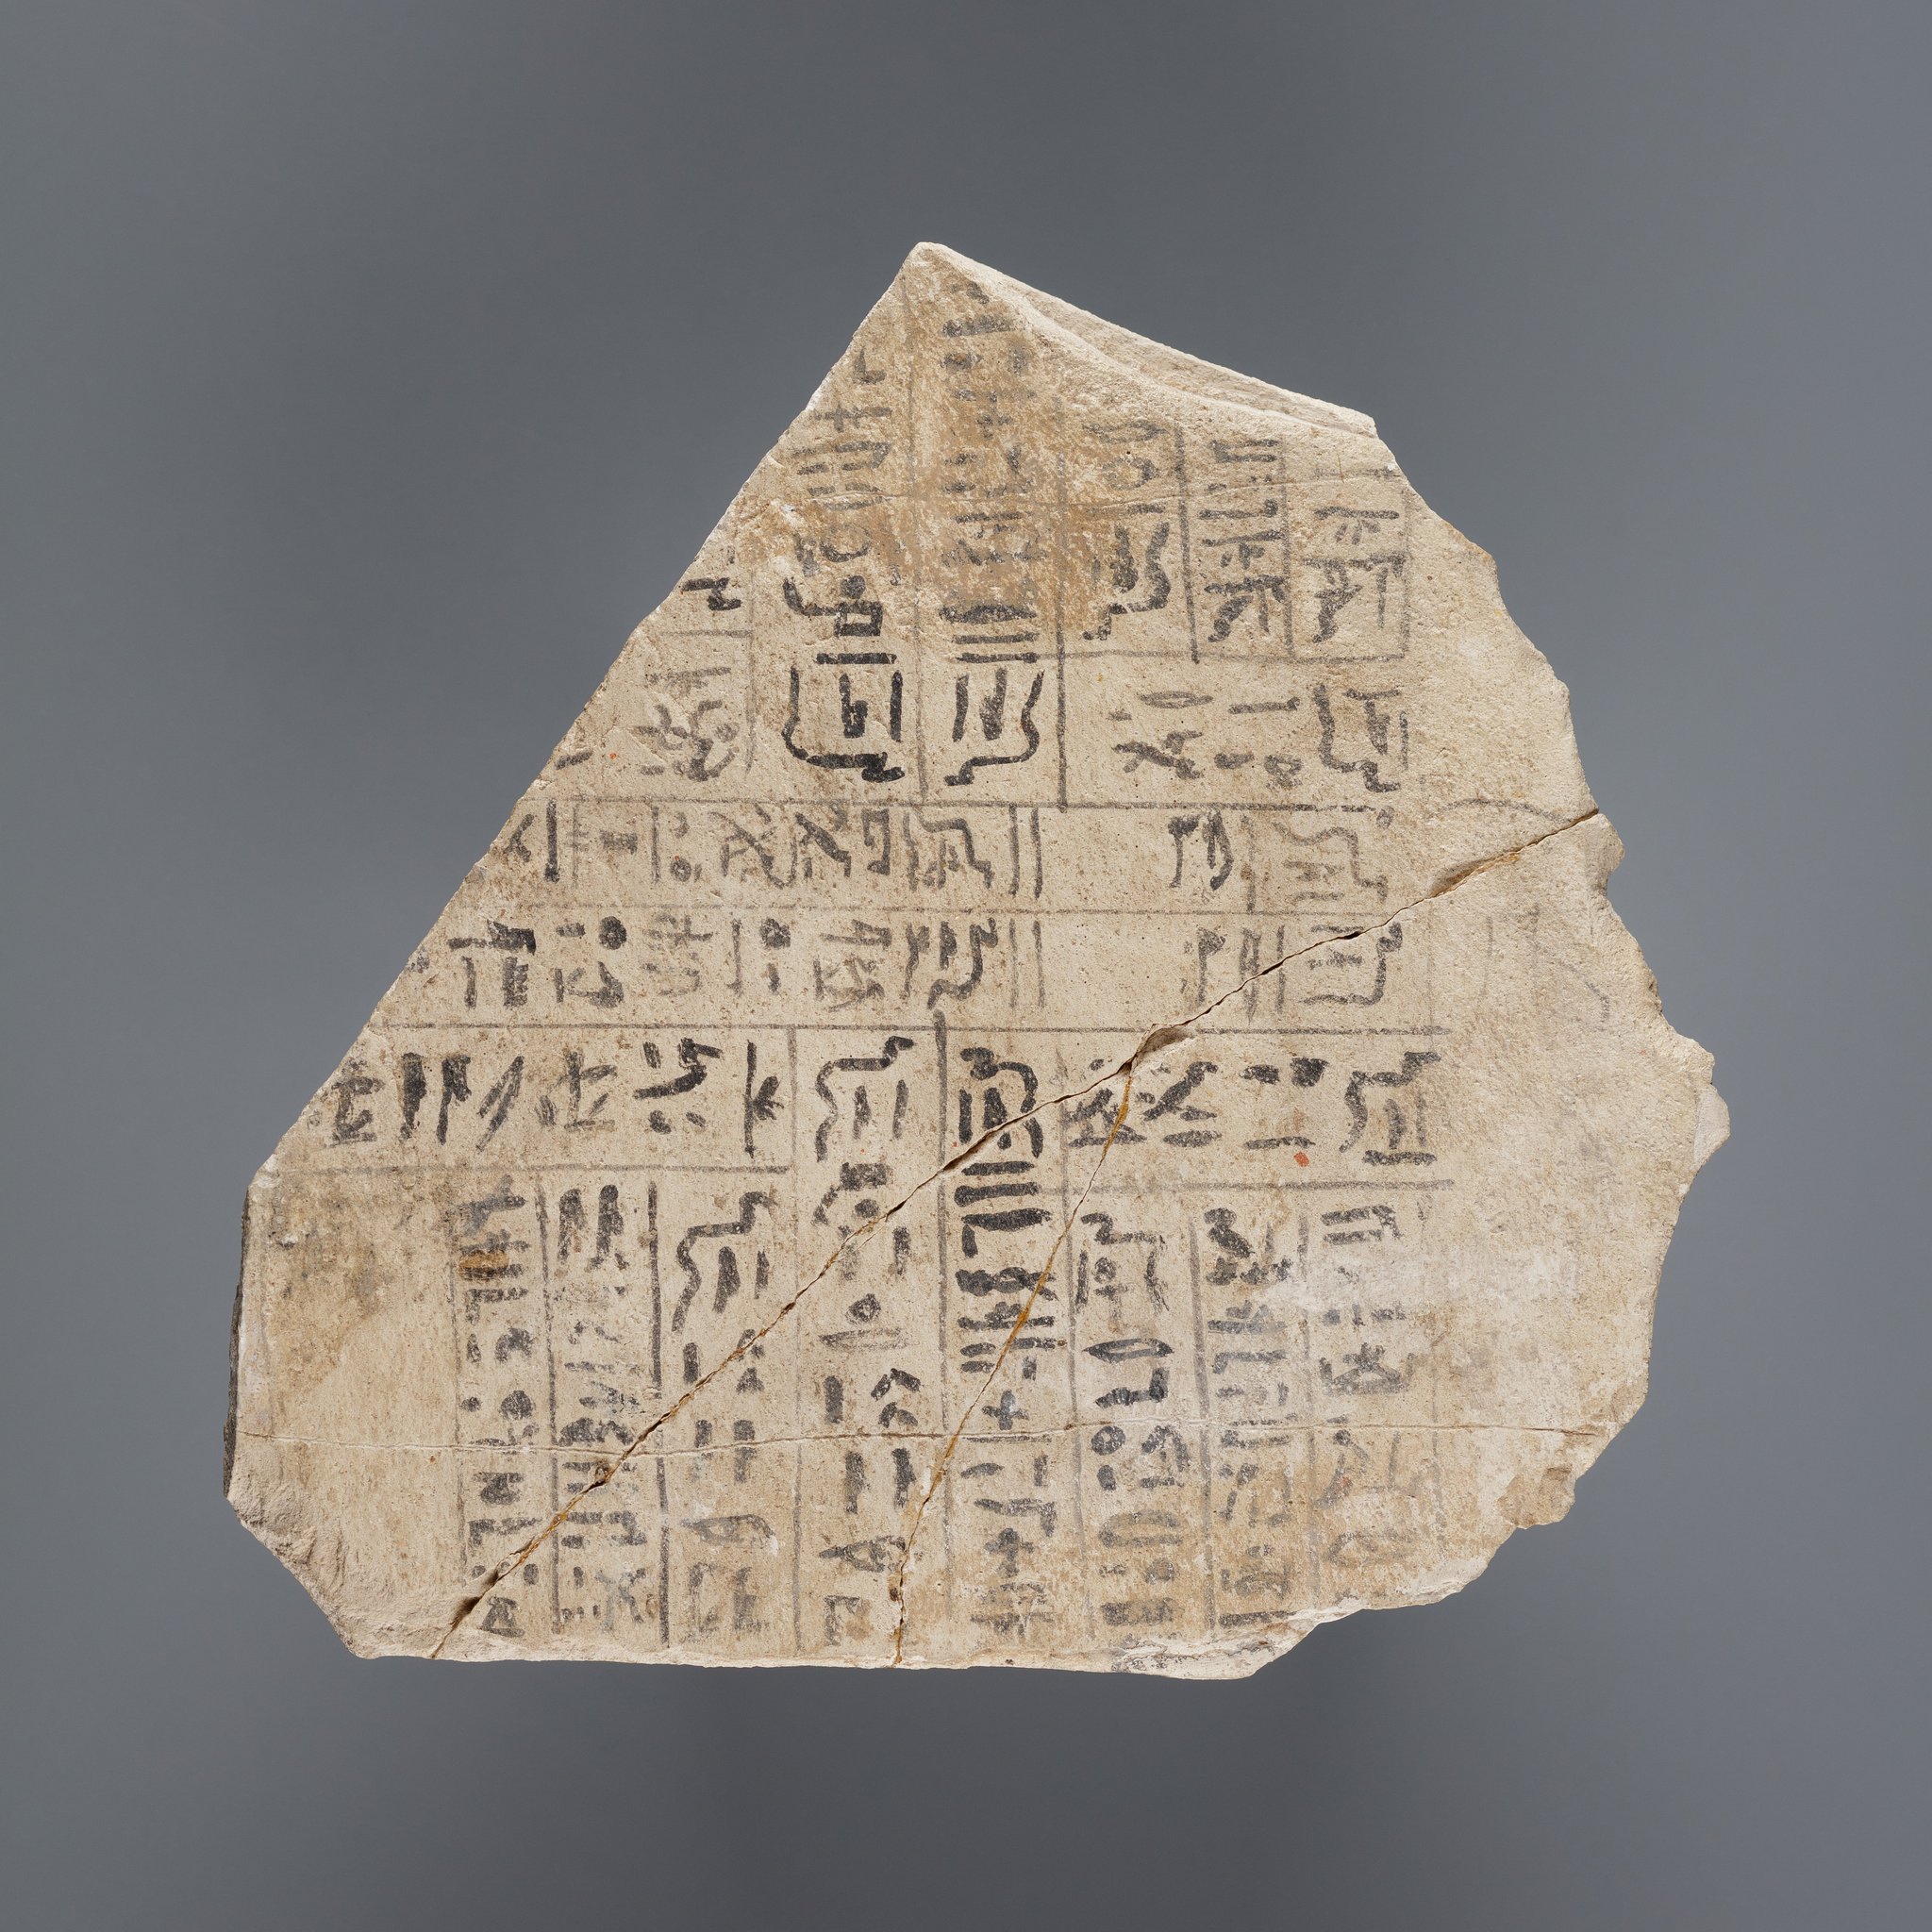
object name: ostracon, cursive hieroglyphic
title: Ostracon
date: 1295-1070 BCE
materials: ink, limestone